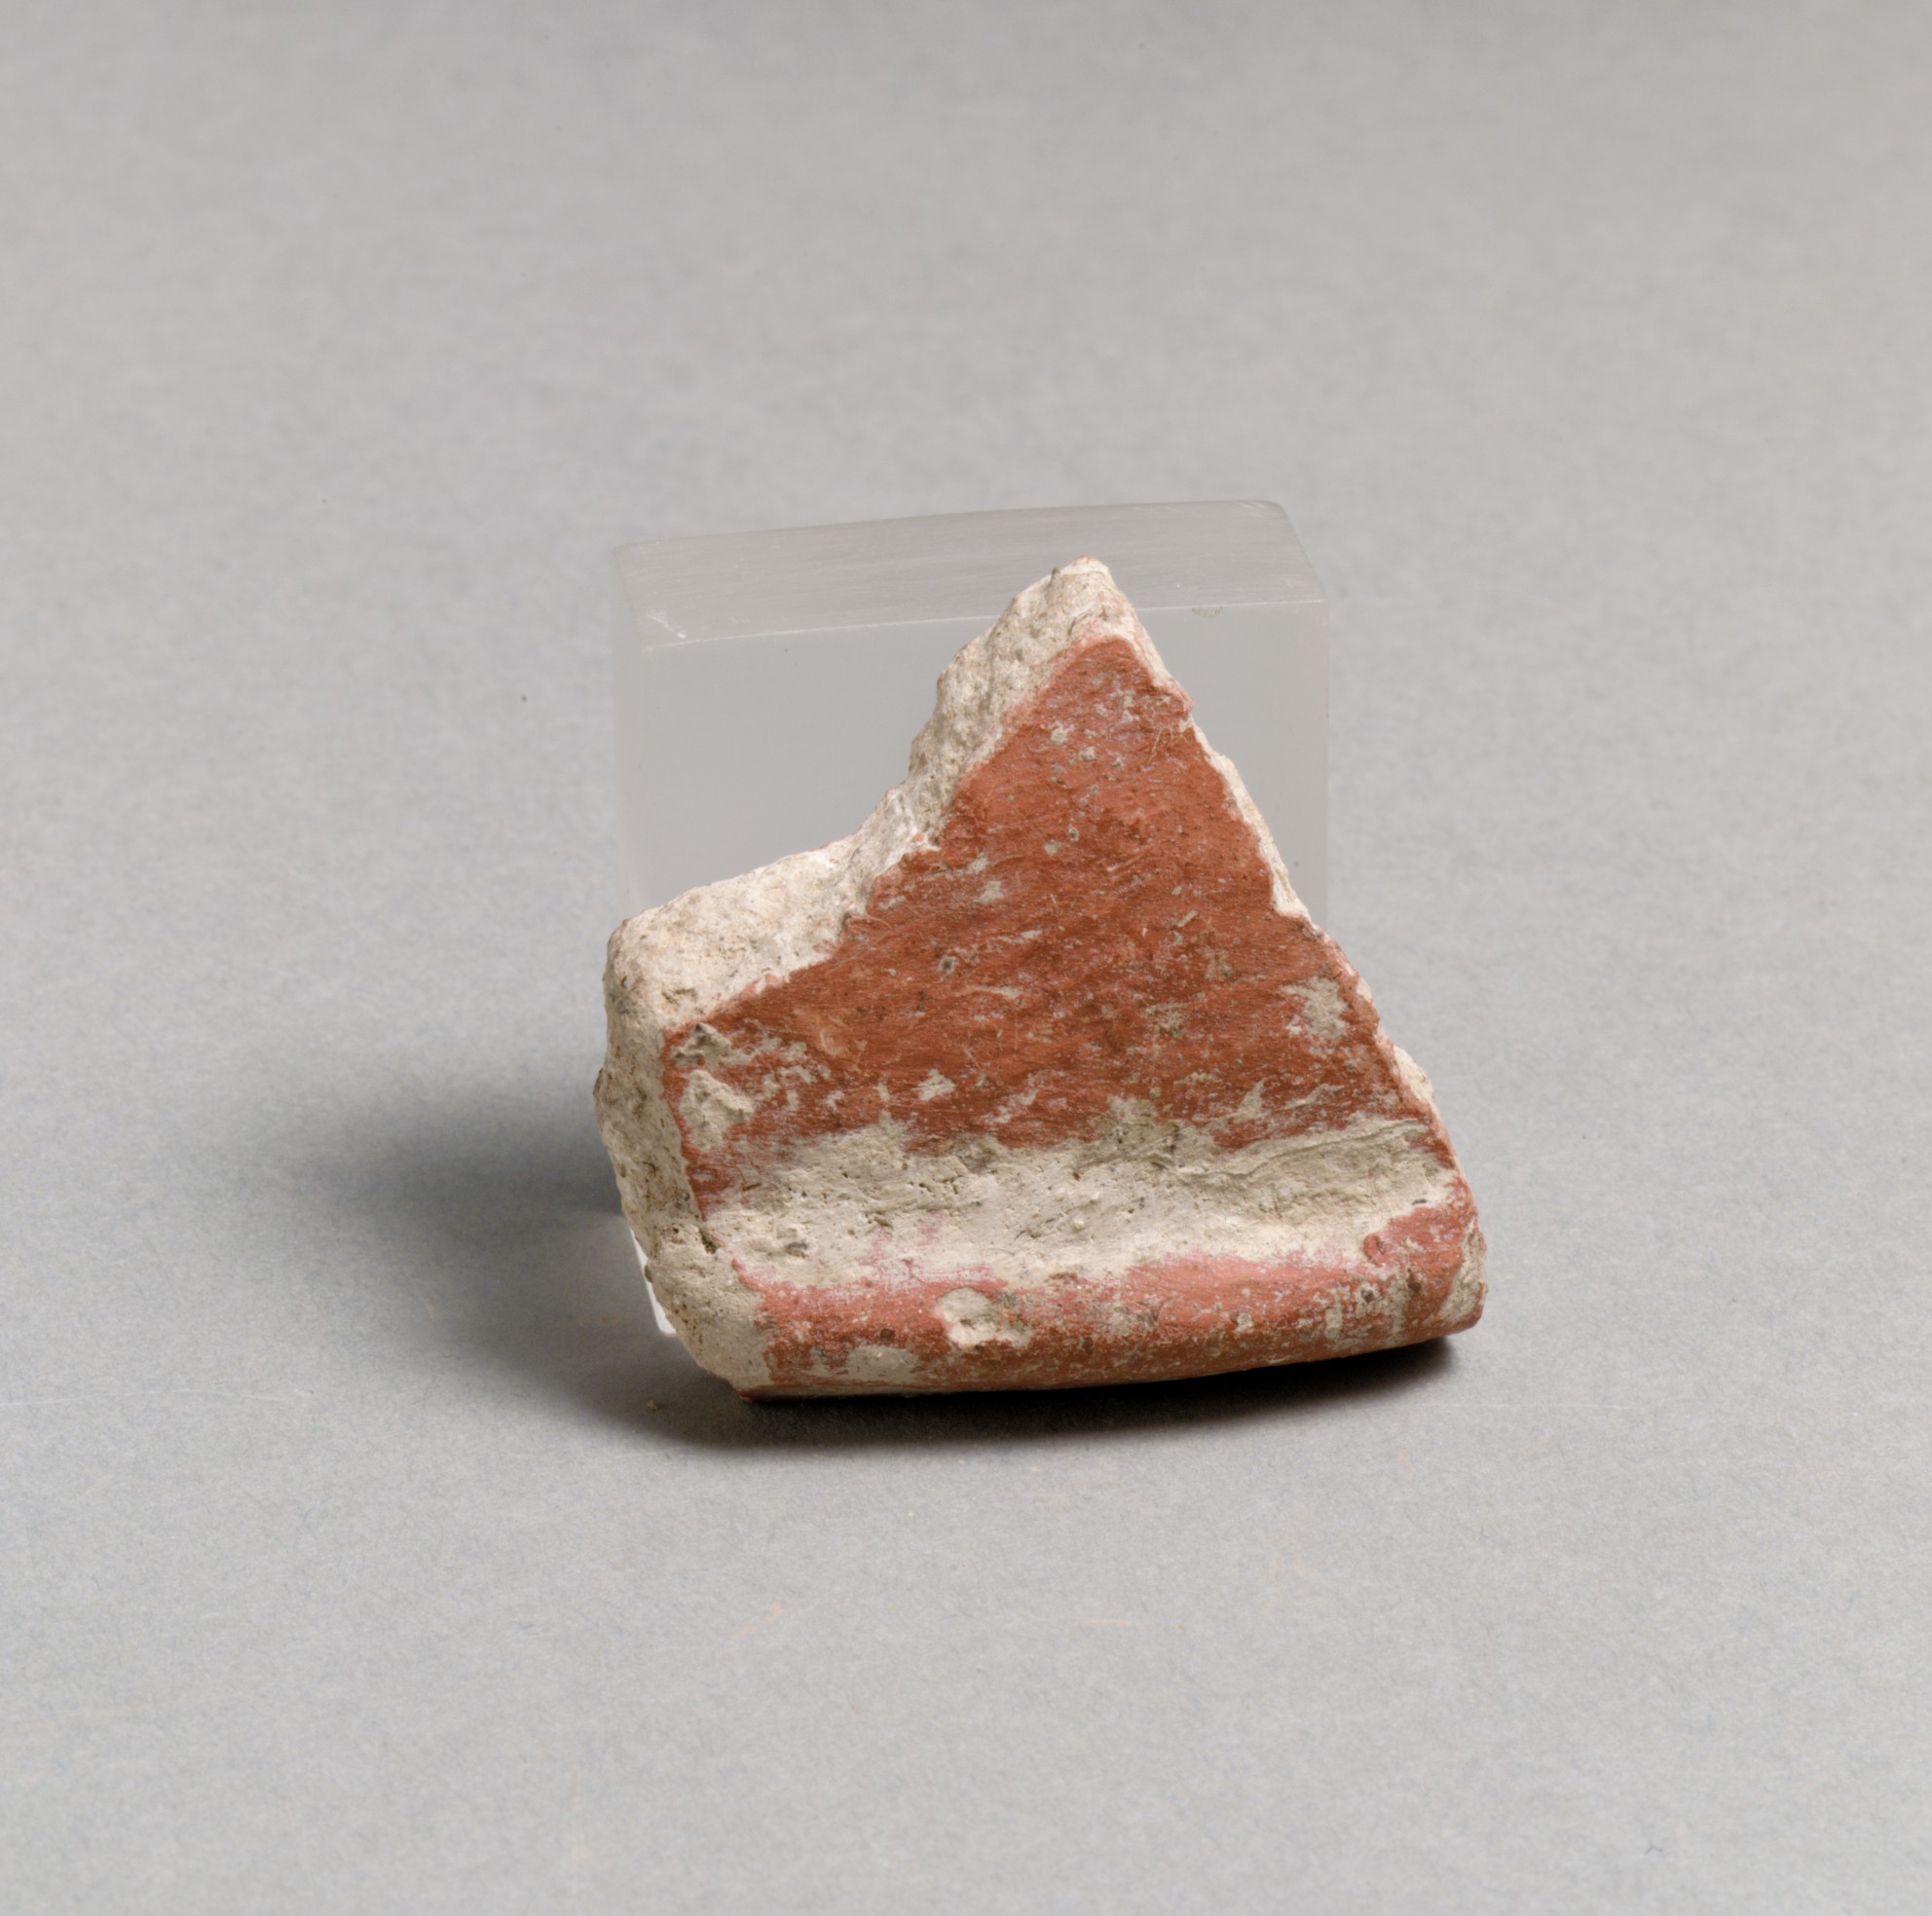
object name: vase fragment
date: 3000-2200 BCE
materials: terracotta